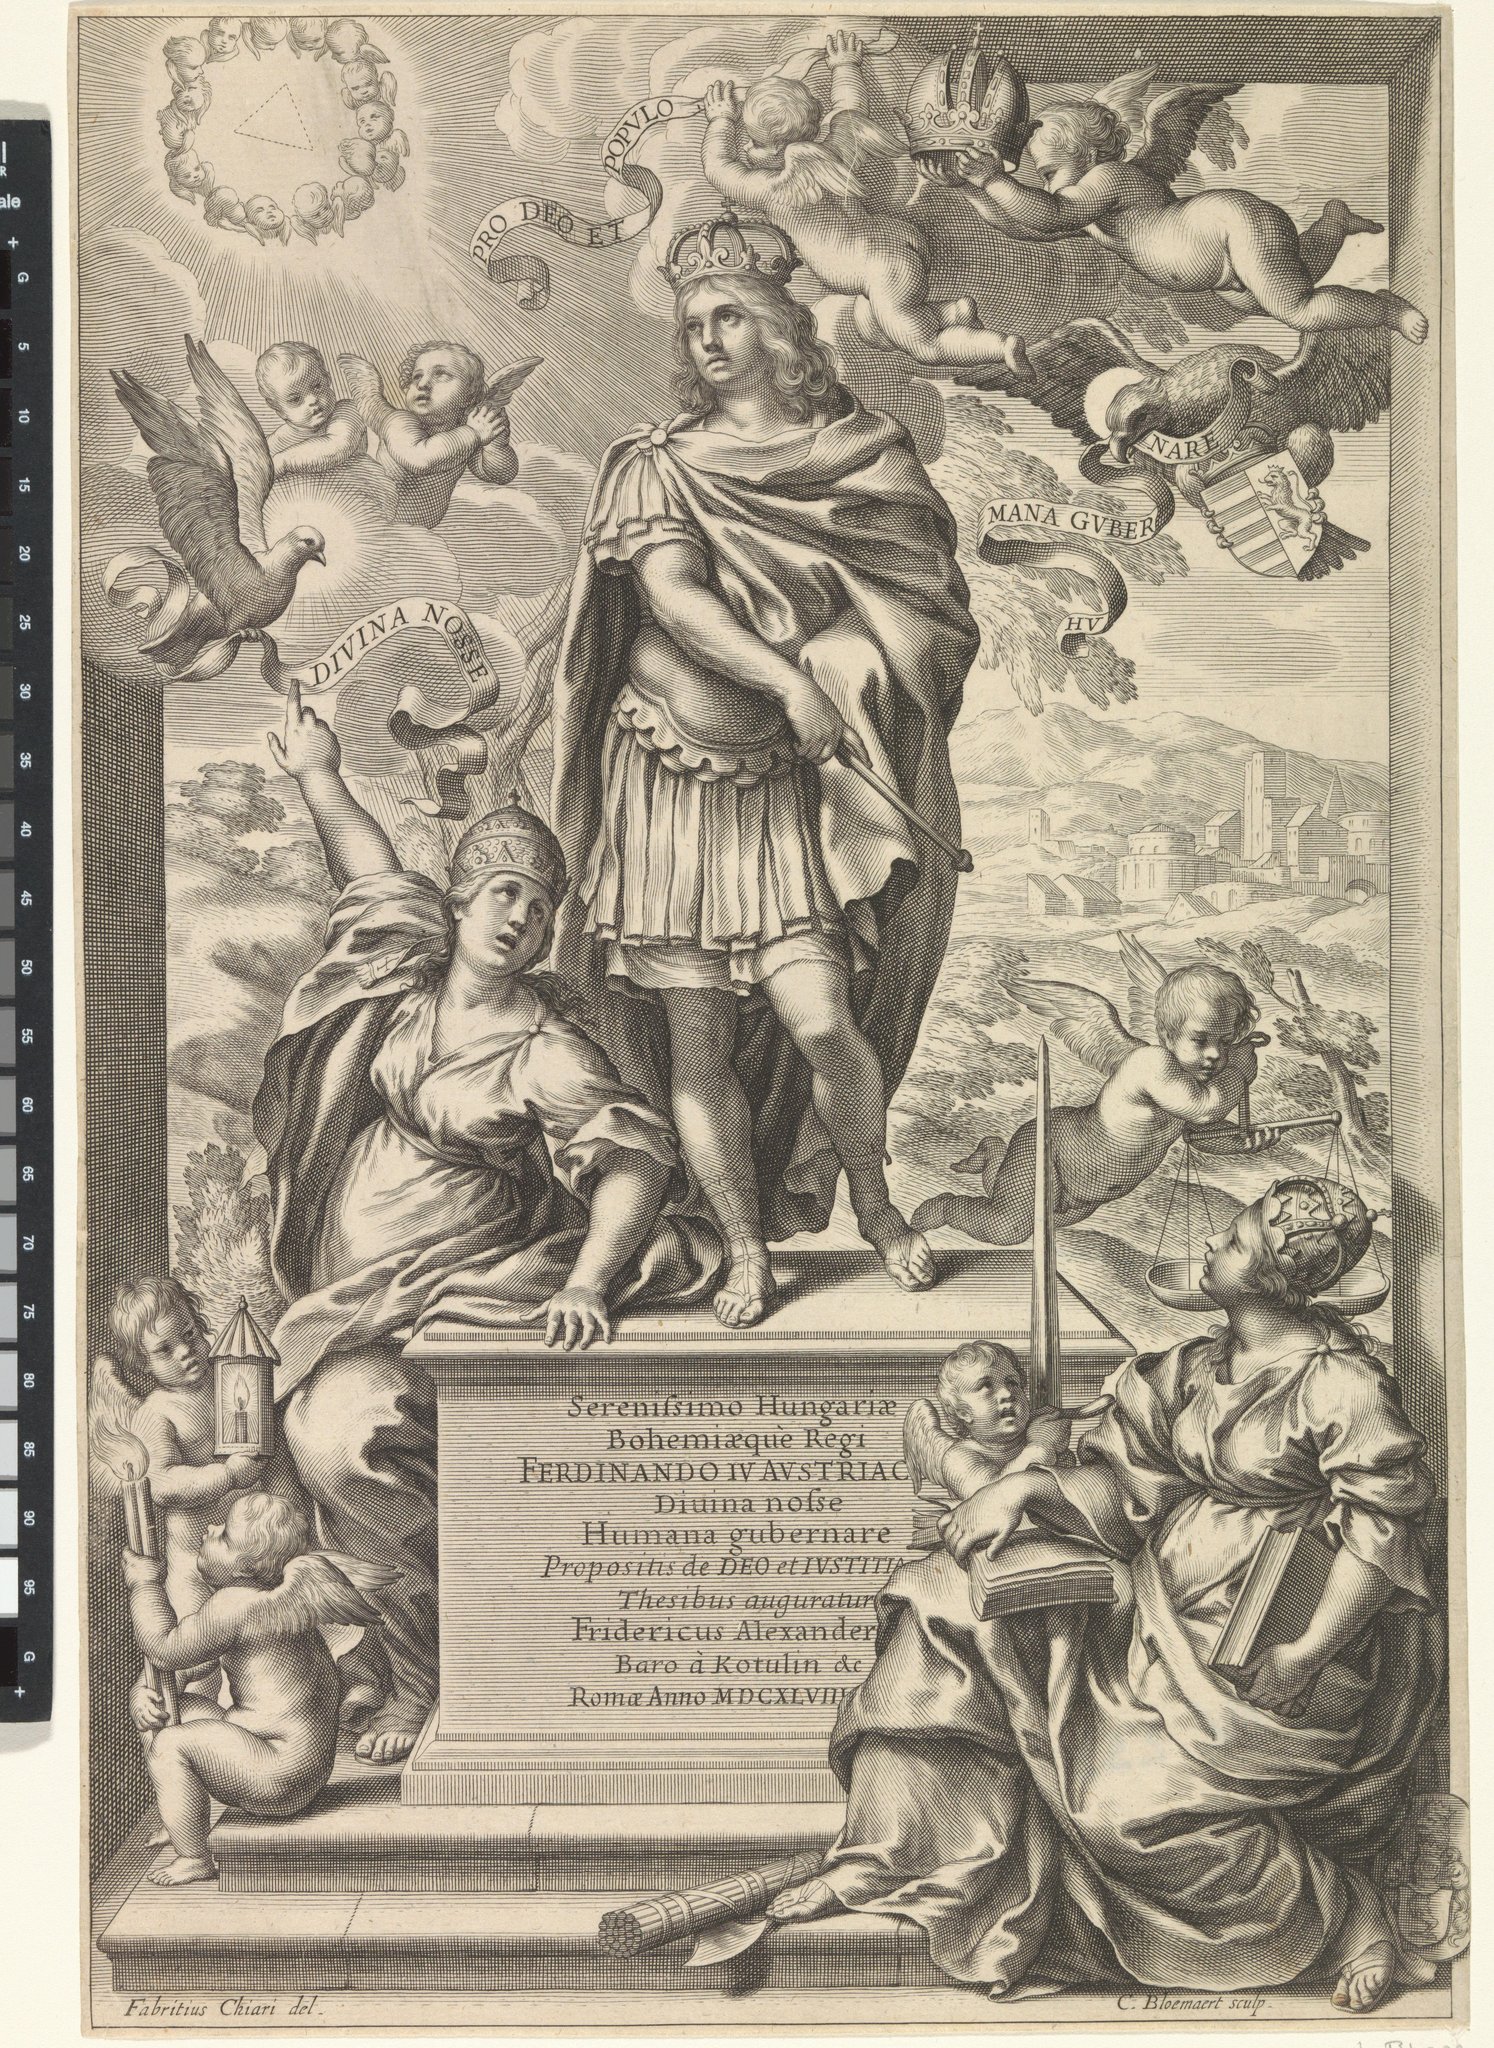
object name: print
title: Koning Ferdinand IV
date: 1648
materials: paper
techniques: engraving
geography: rome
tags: vienna, emperor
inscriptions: collector's mark: Lugt 240, inscription: ‘P. Mariette 1648’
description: Koning Ferdinand IV op een sokkel, omgeven door allegorische figuren. Boven hem zweven engeltjes. Een van de engelen heeft een kroon in zijn handen. Aan de voet van de sokkel zit Justitia. Waarschijnlijk wordt er door de tweede kroon een toespeling gemaakt op de naderende kroning van Ferdinand tot keizer van het Heilige Roomse Rijk.